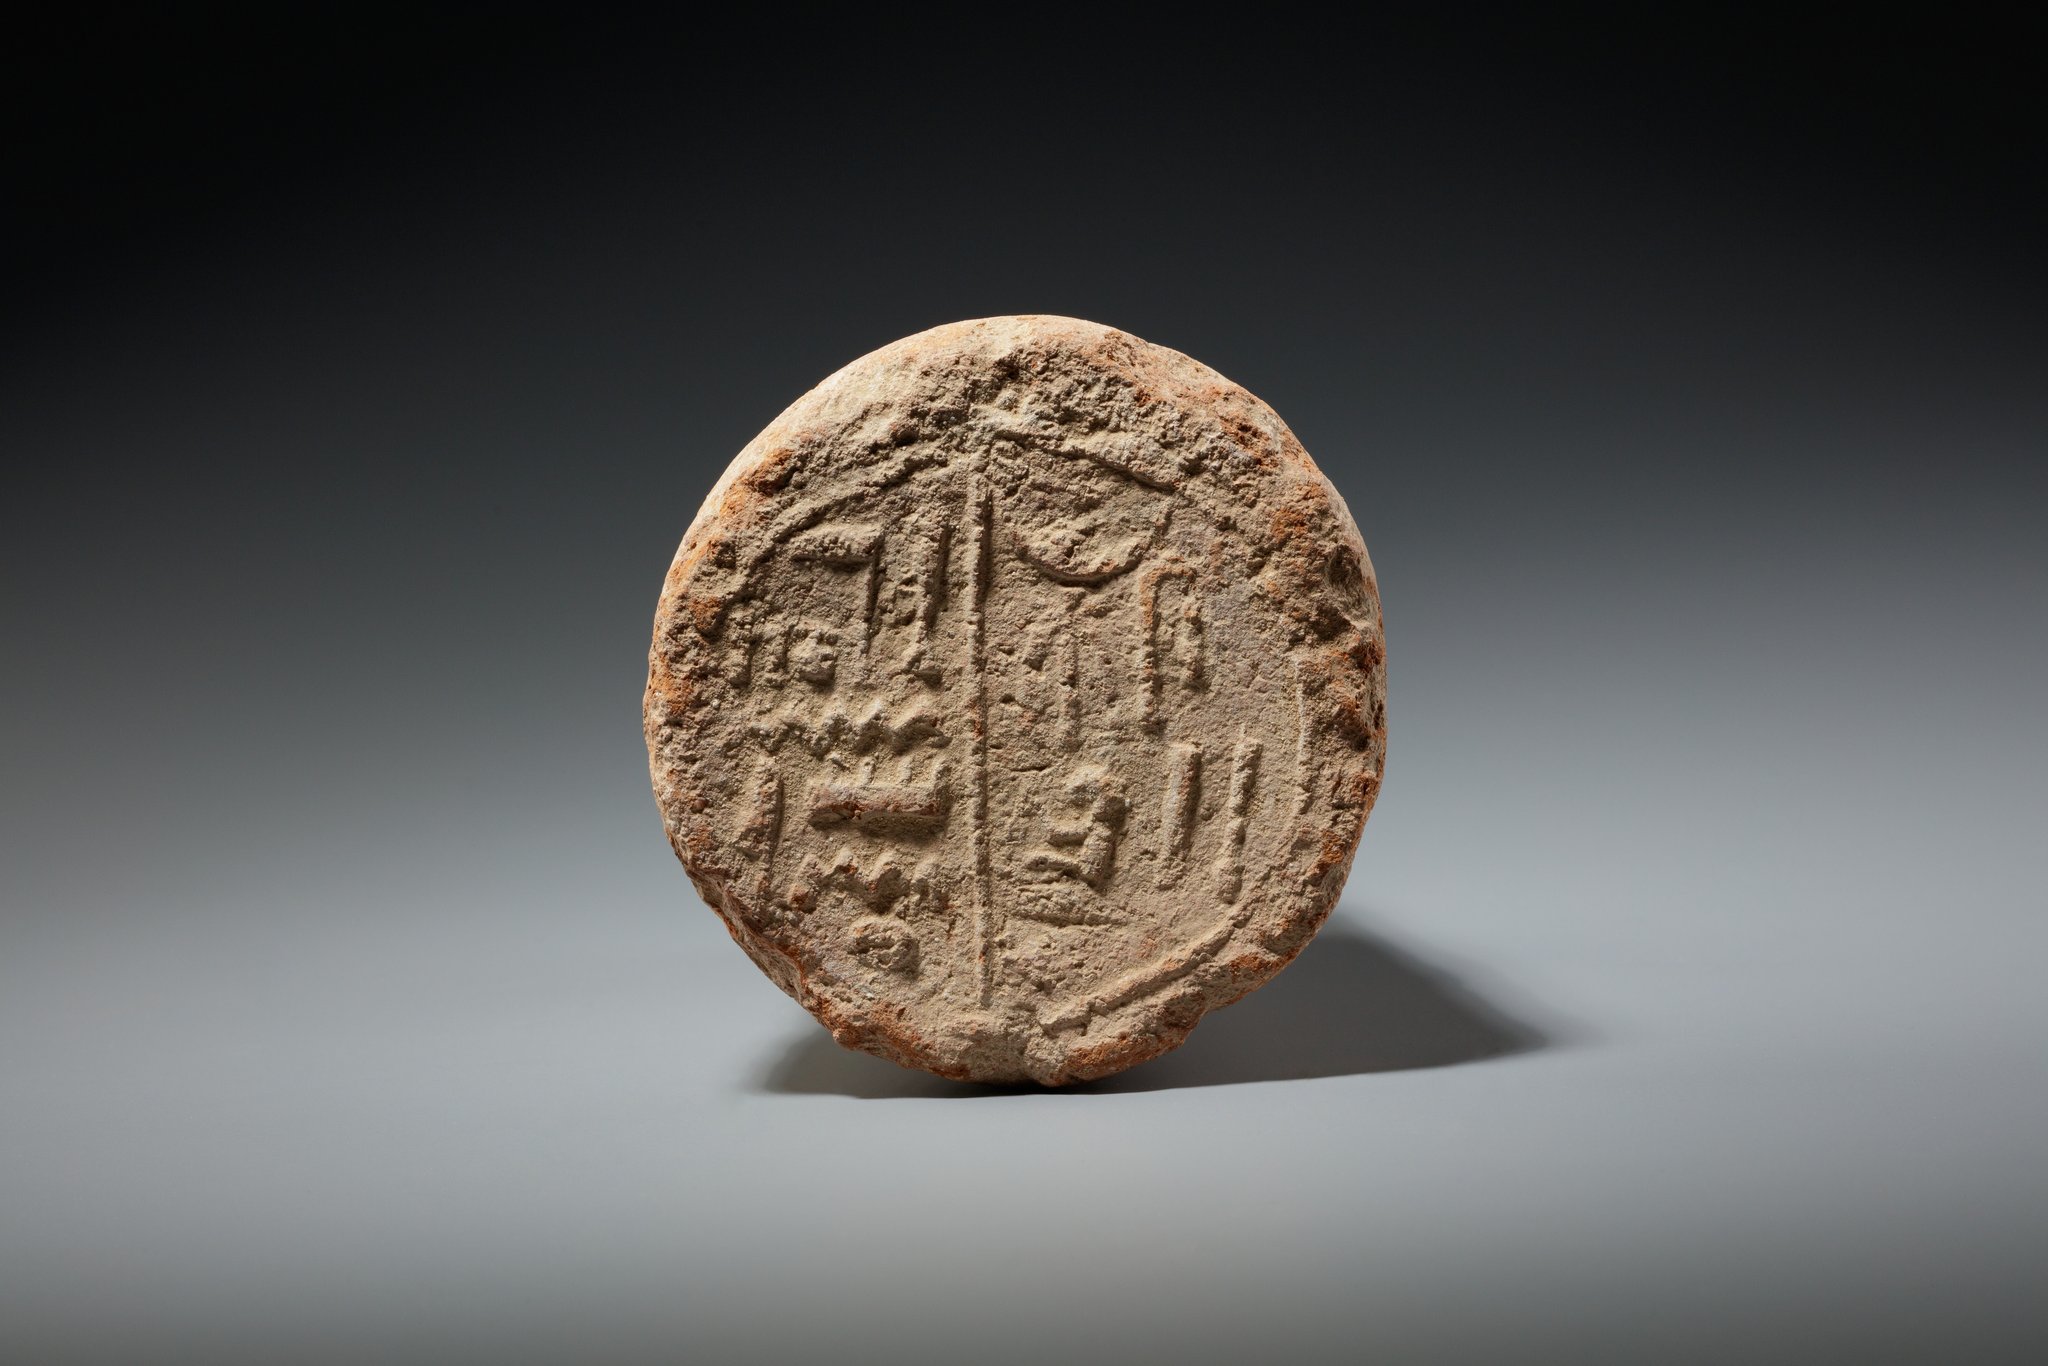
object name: cone, davy 300, ahmose, high priest, amun, thutmose iii, tt 121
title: Funerary Cone of the High Priest Ahmose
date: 1479-1425 BCE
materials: pottery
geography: egypt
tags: hieroglyphs